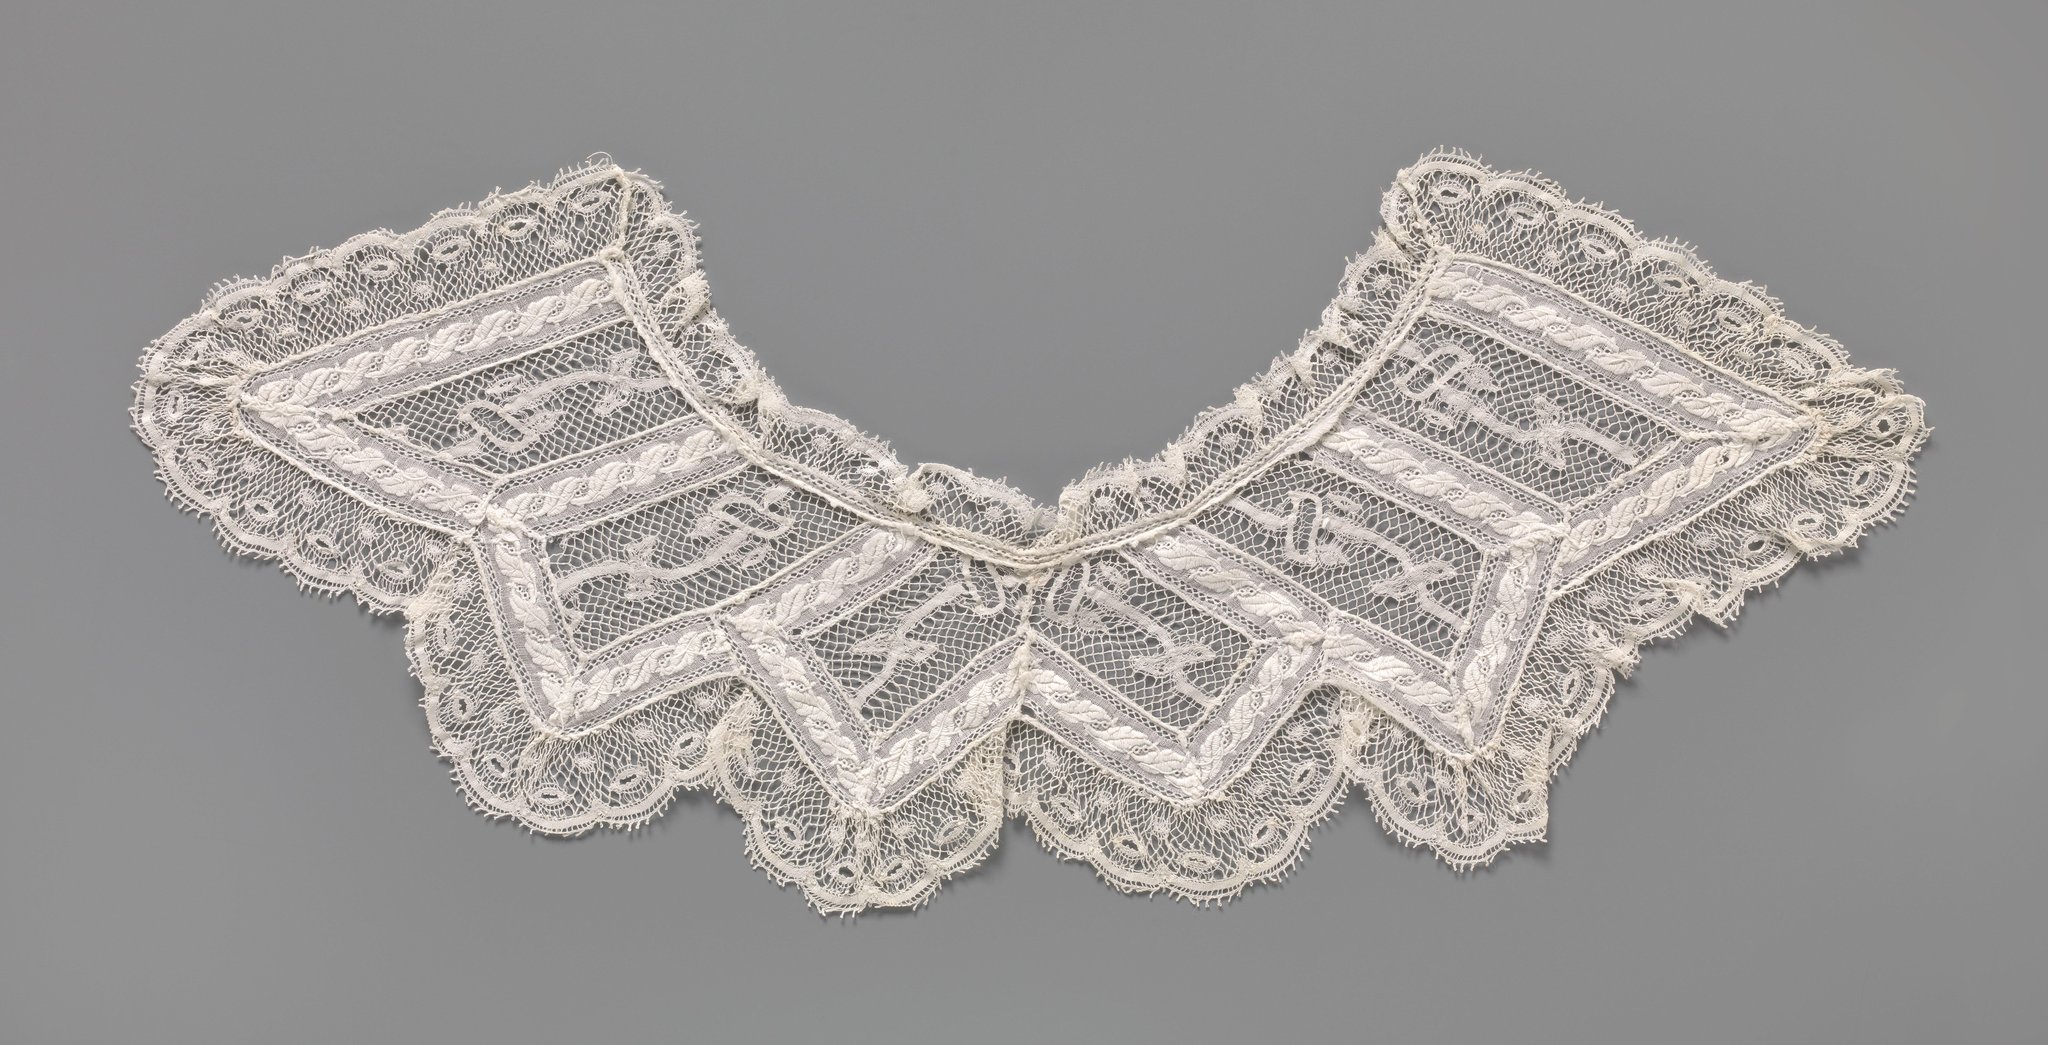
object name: collar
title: Kinderkraag van kloskant met hoekige schulpen en tussenzetsels van batist met borduurwerk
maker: Anonymous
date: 1875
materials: textile, cotton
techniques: lace, embroidered, weave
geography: netherlands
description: Kinderkraag van naturelkleurig kloskant - Valenciennes-kant - met tussenzetsels van batist met borduurwerk - witwerk - rond hoekige straalsgewijze velden. De kraag is rondom afgewerkt met stroken Valenciennes-kant, waarbij de strook langs de neklijn smaller is dan de strook die een schulpenrand vormt rondom de hoekige velden.